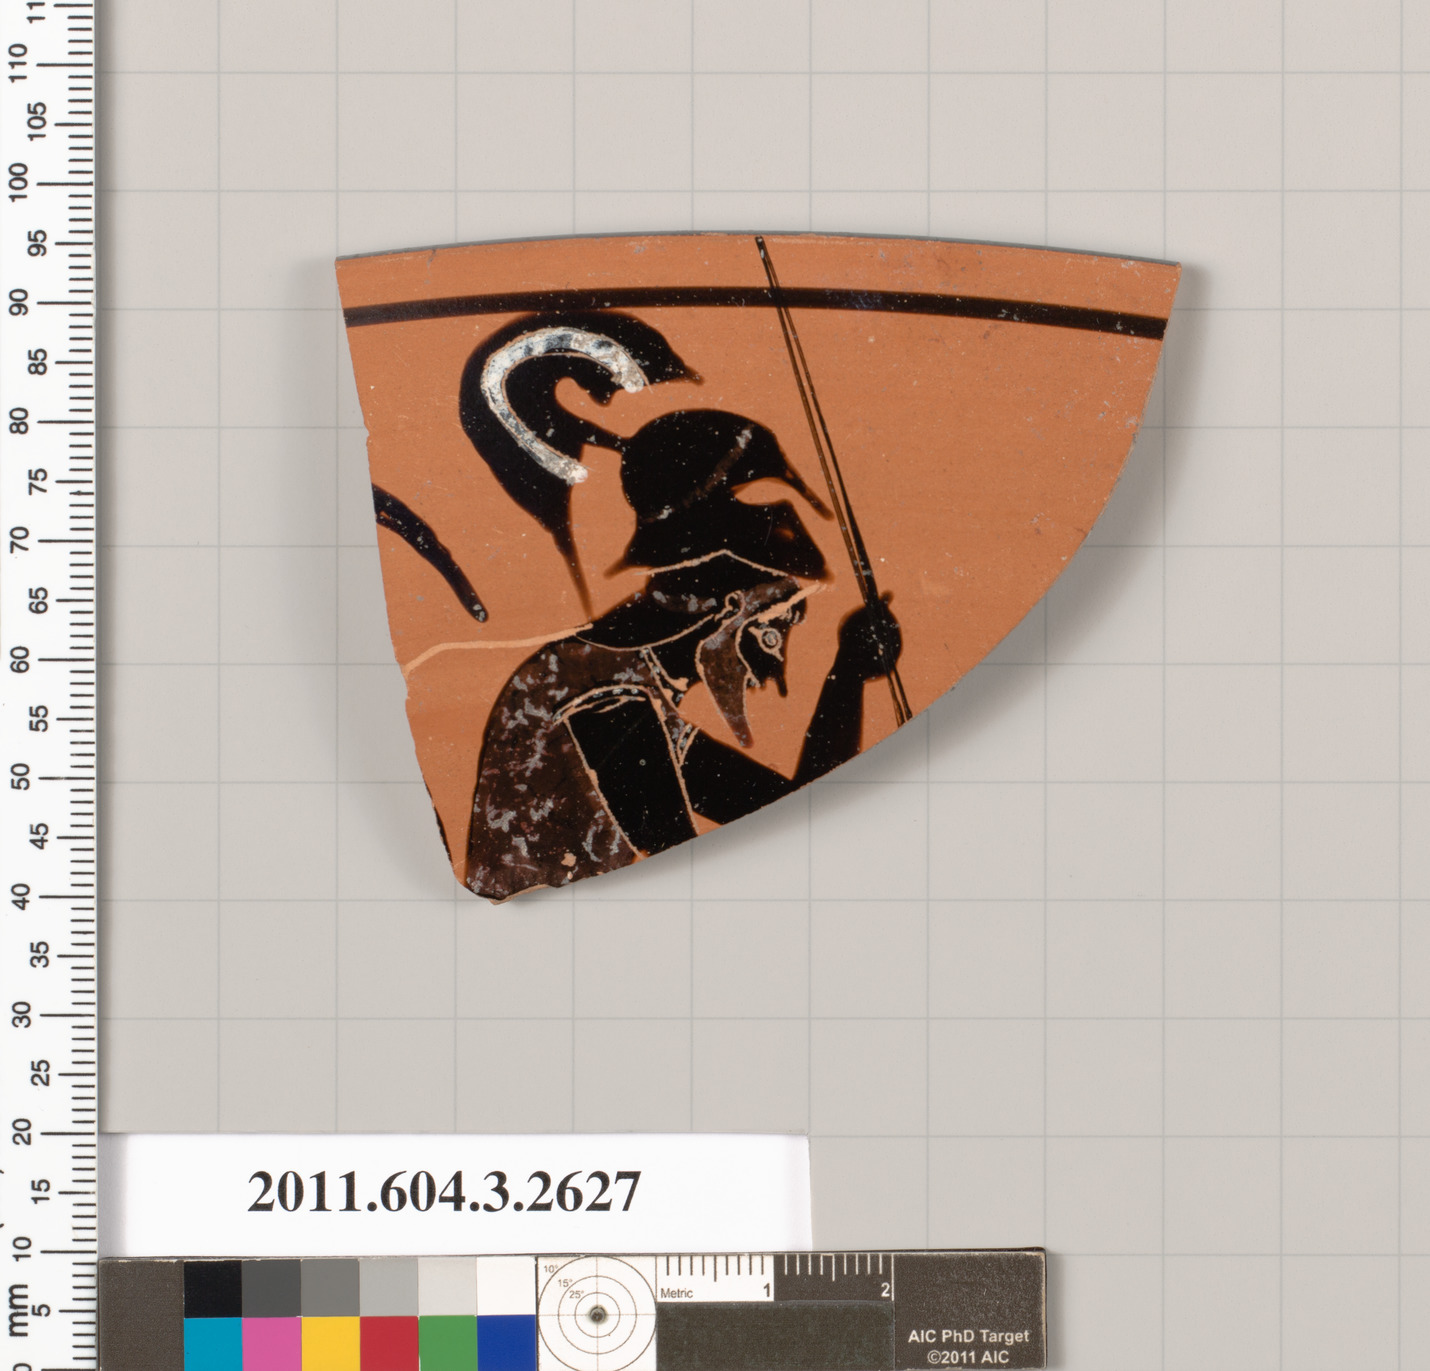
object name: kylix fragment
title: Terracotta rim fragment of a kylix (drinking cup)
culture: greek, attic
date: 540-530 BCE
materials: terracotta